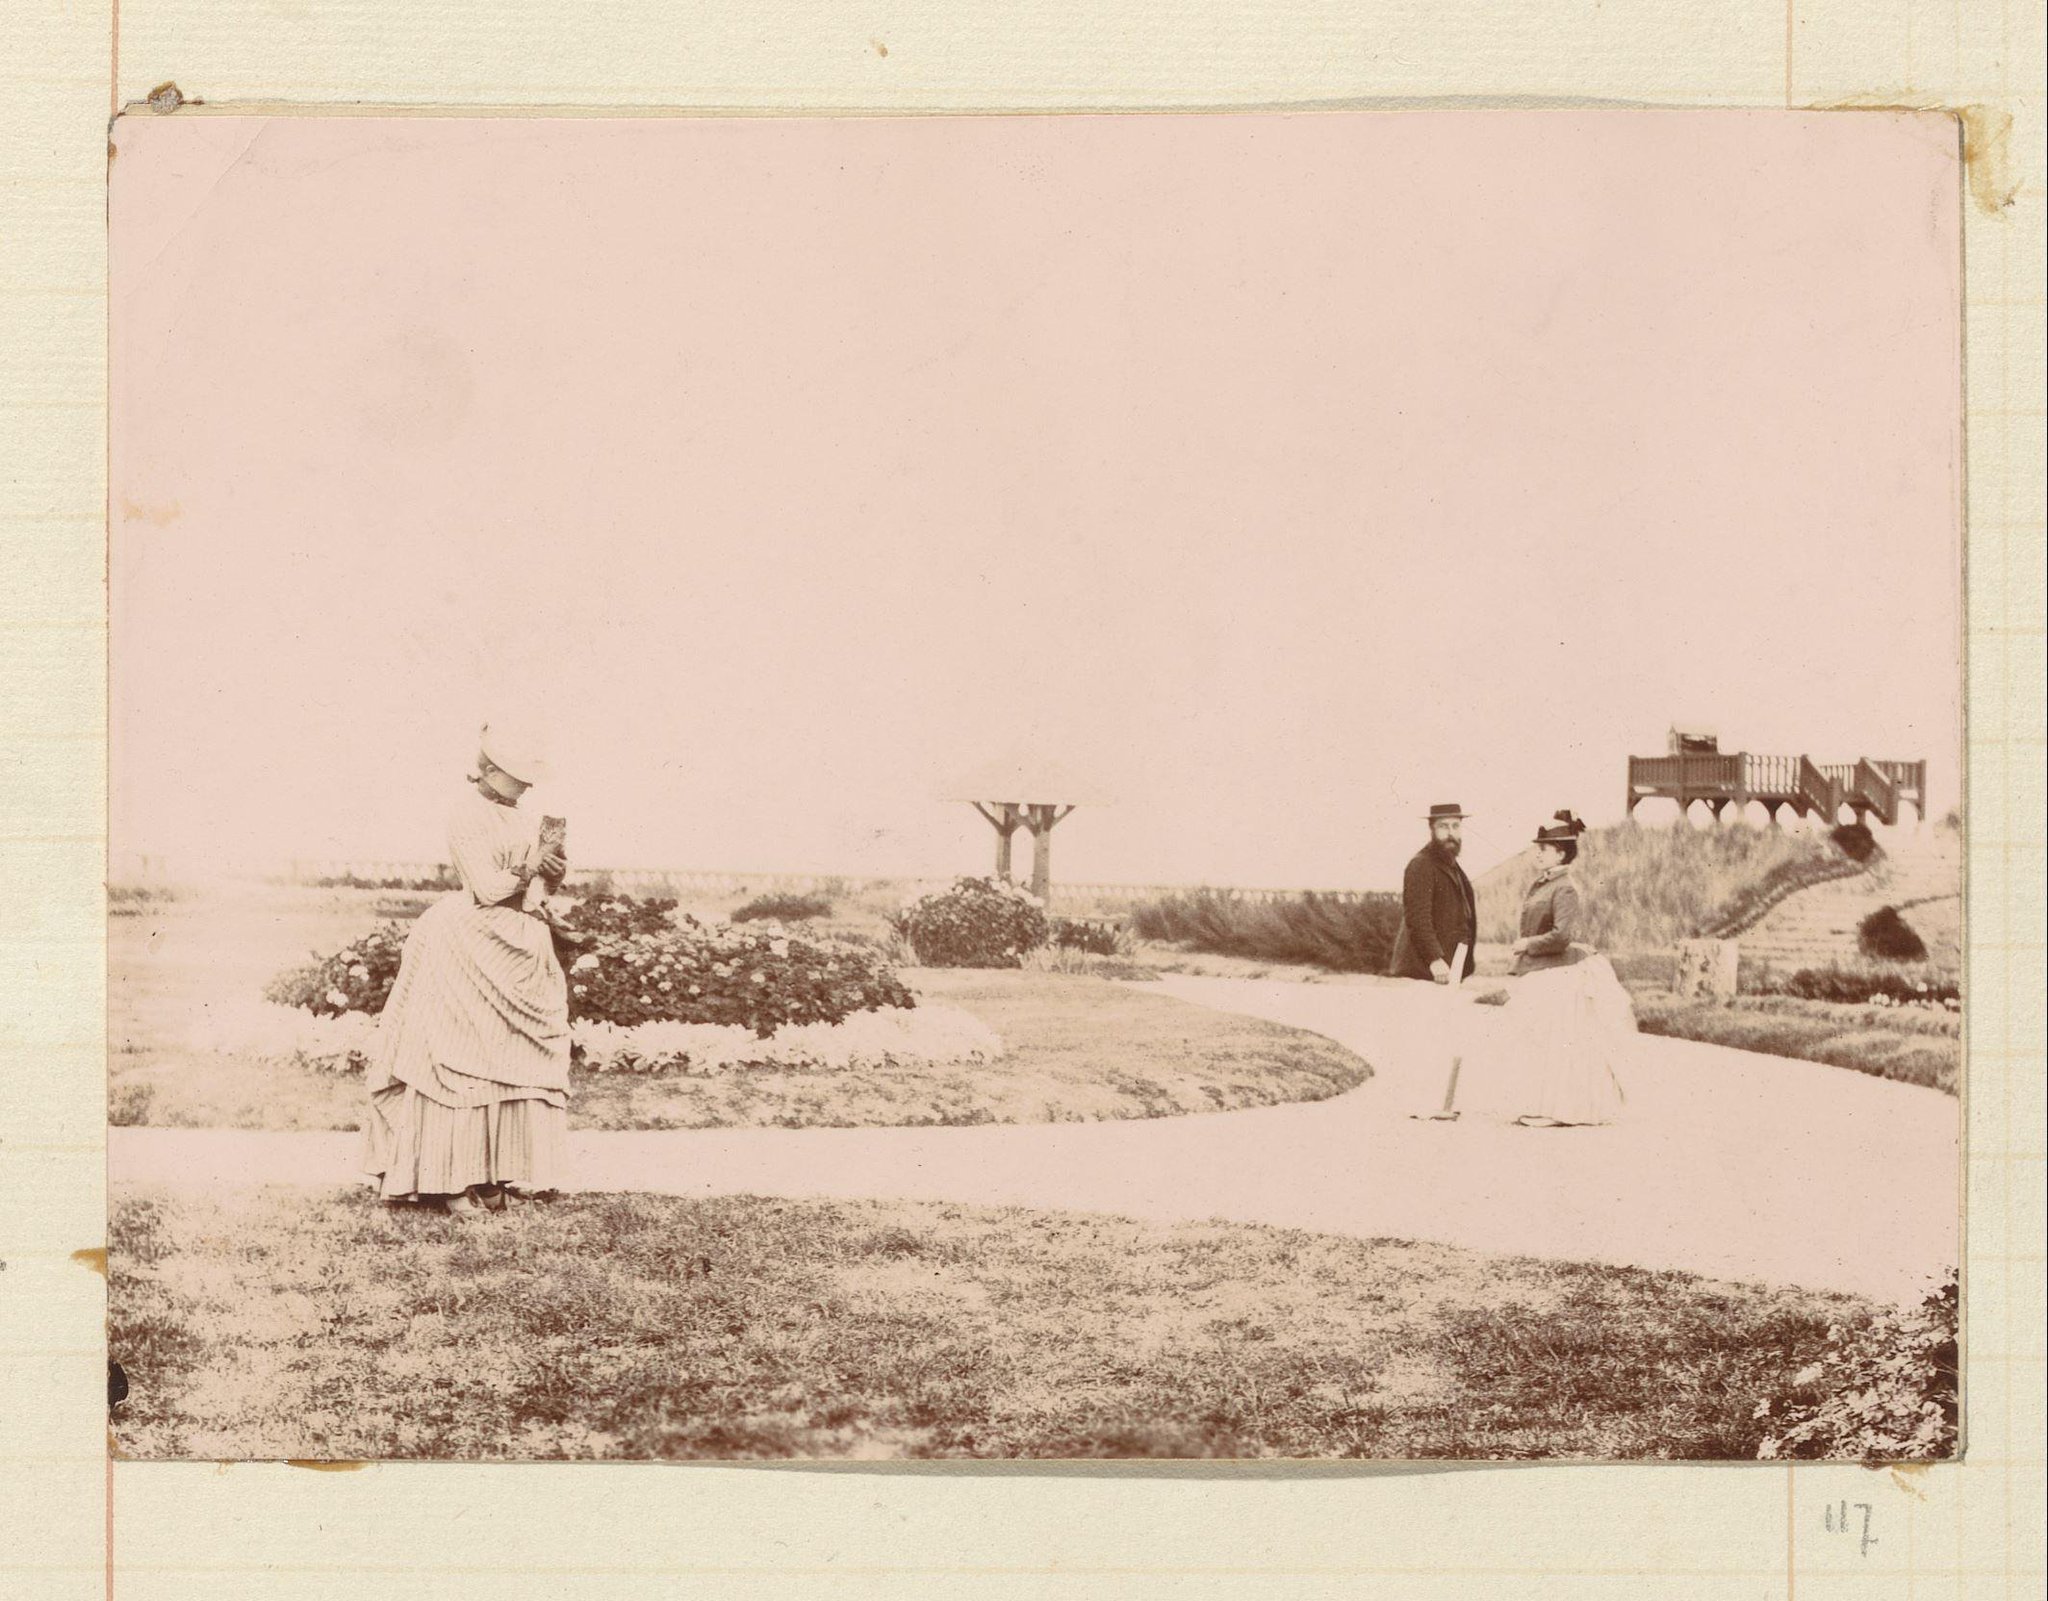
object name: photograph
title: Man, twee vrouwen en een jonge kat op een tuinpad bij een uitkijkpost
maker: Anonymous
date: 1880-1900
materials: paper, photographic support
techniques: gelatin silver print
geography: france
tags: adult woman, cat, adult man, dress, gown